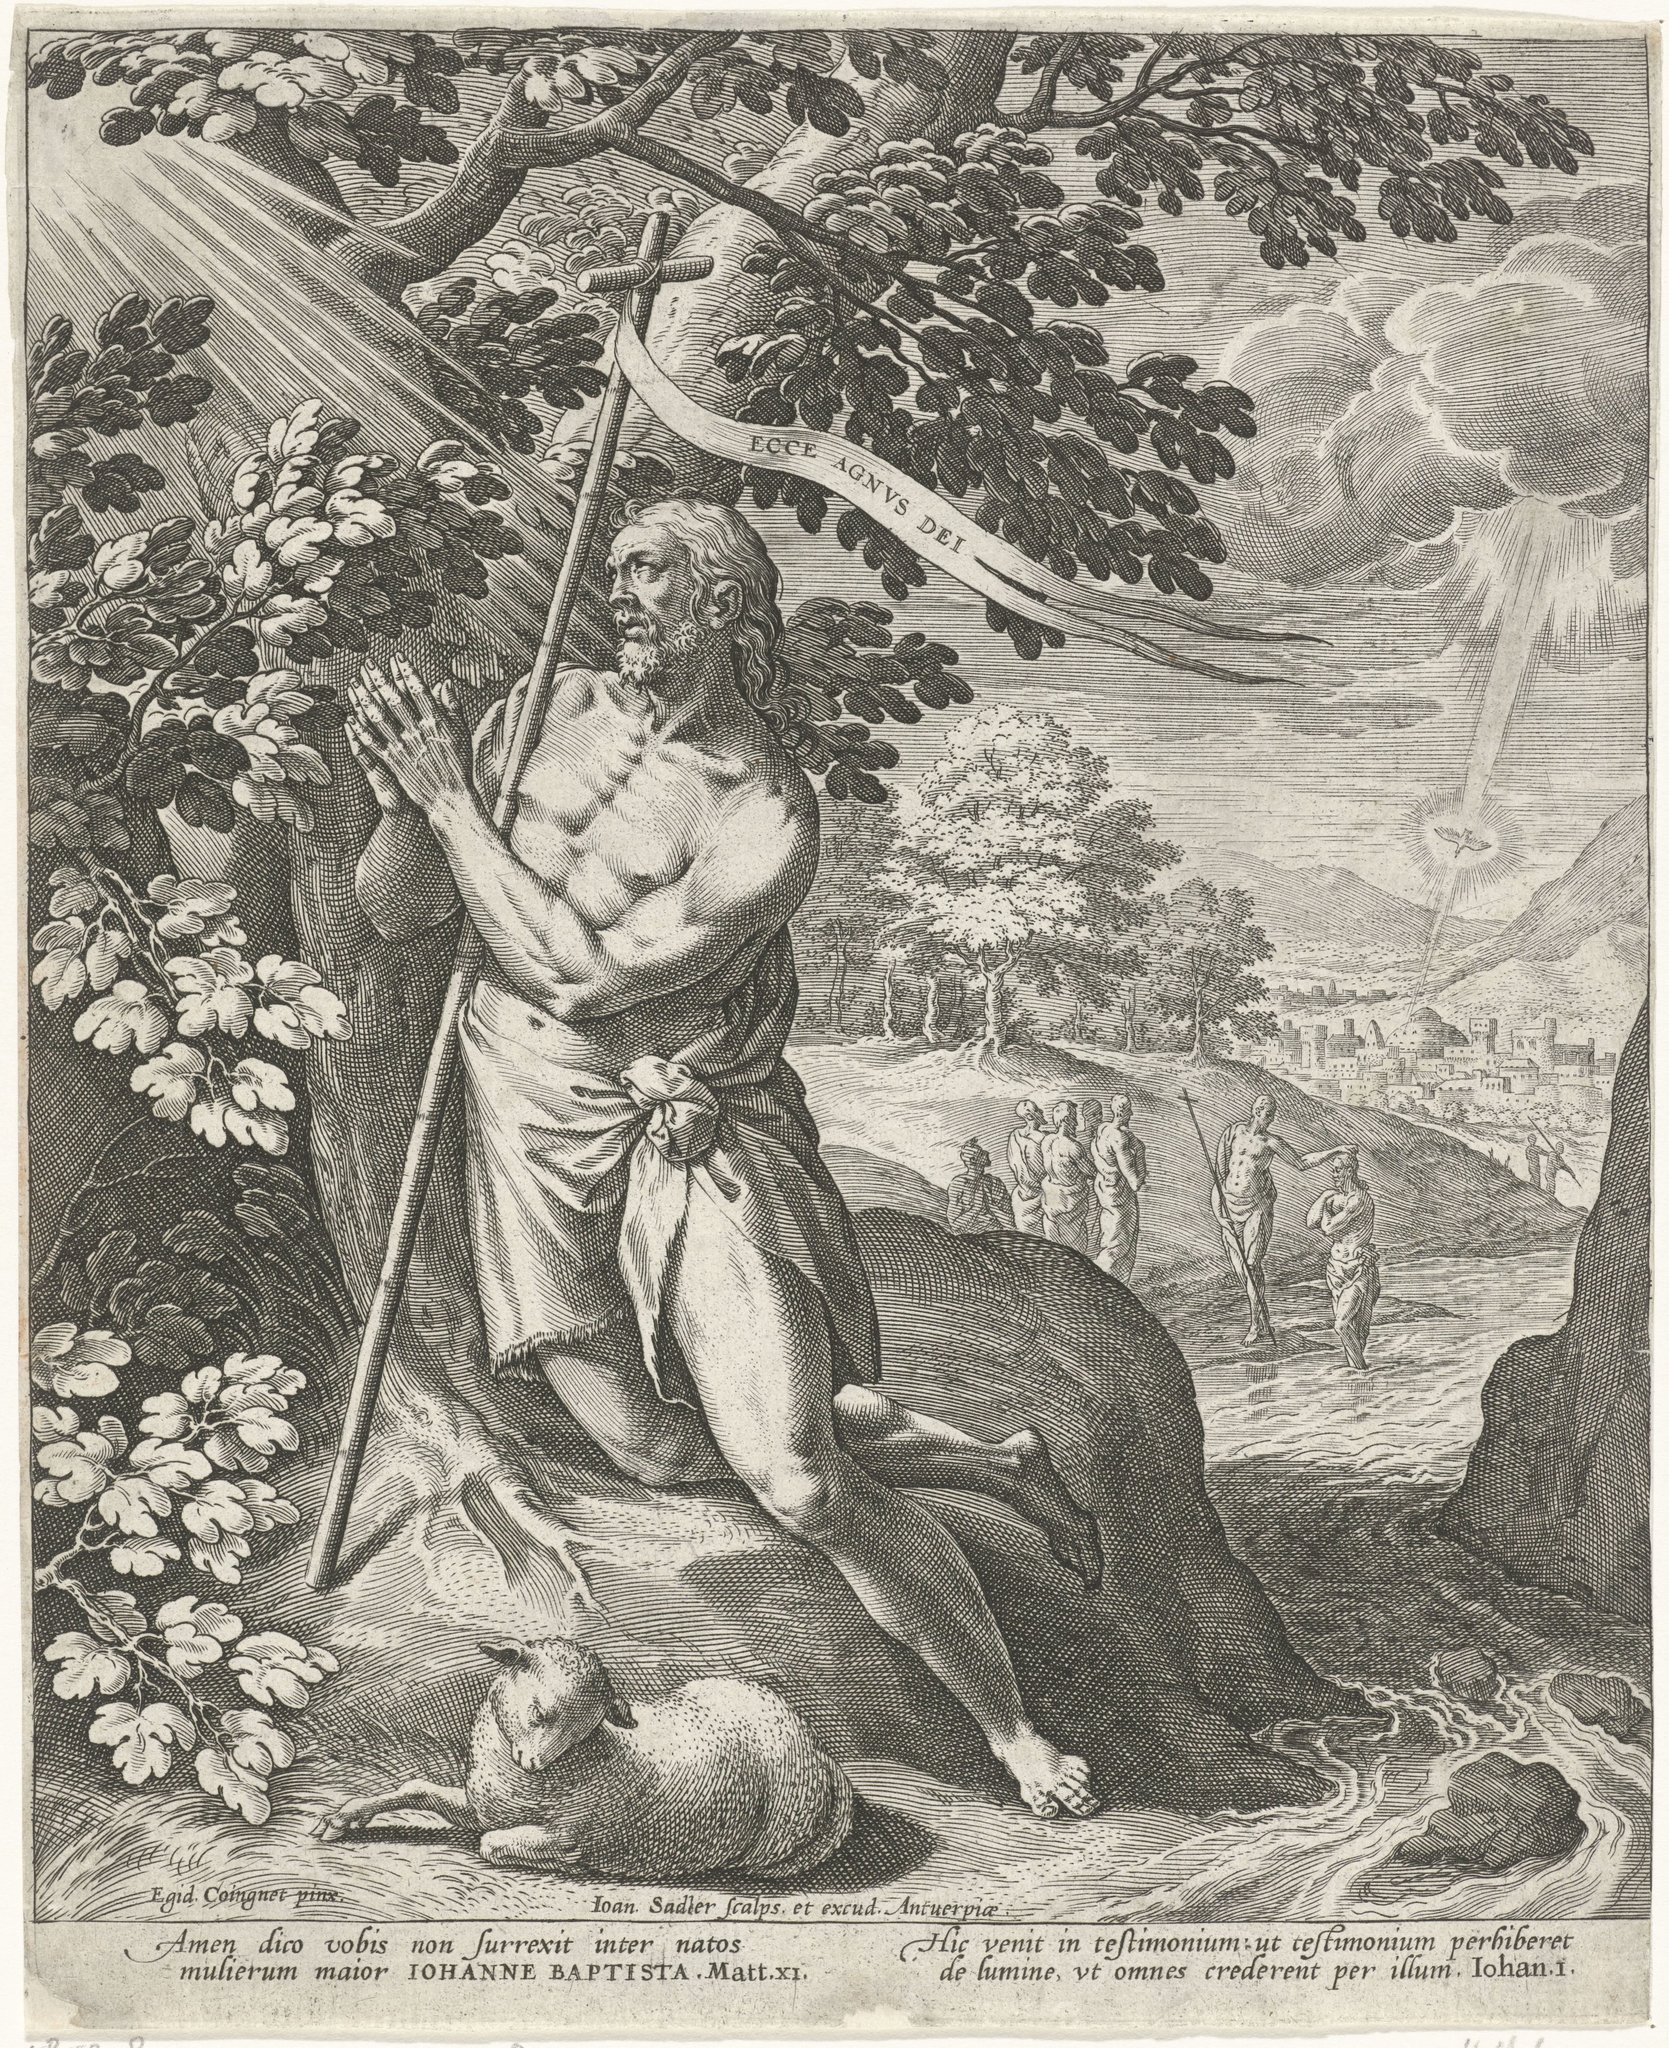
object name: print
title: Johannes de Doper in de woestijn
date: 1560-1586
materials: paper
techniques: engraving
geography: antwerp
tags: baptism of christ in the river jordan: john the baptist pouring out water on christ's head: the holy ghost descends, john the baptist in the wilderness, usually accompanied by a lamb, john the baptist praying and meditating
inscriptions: collector's mark: Lugt 2228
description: Johannes de Doper, biddend op zijn knieën met een crucifix in de handen. Voor hem ligt een lam. Op de achtergrond de doop van Christus.